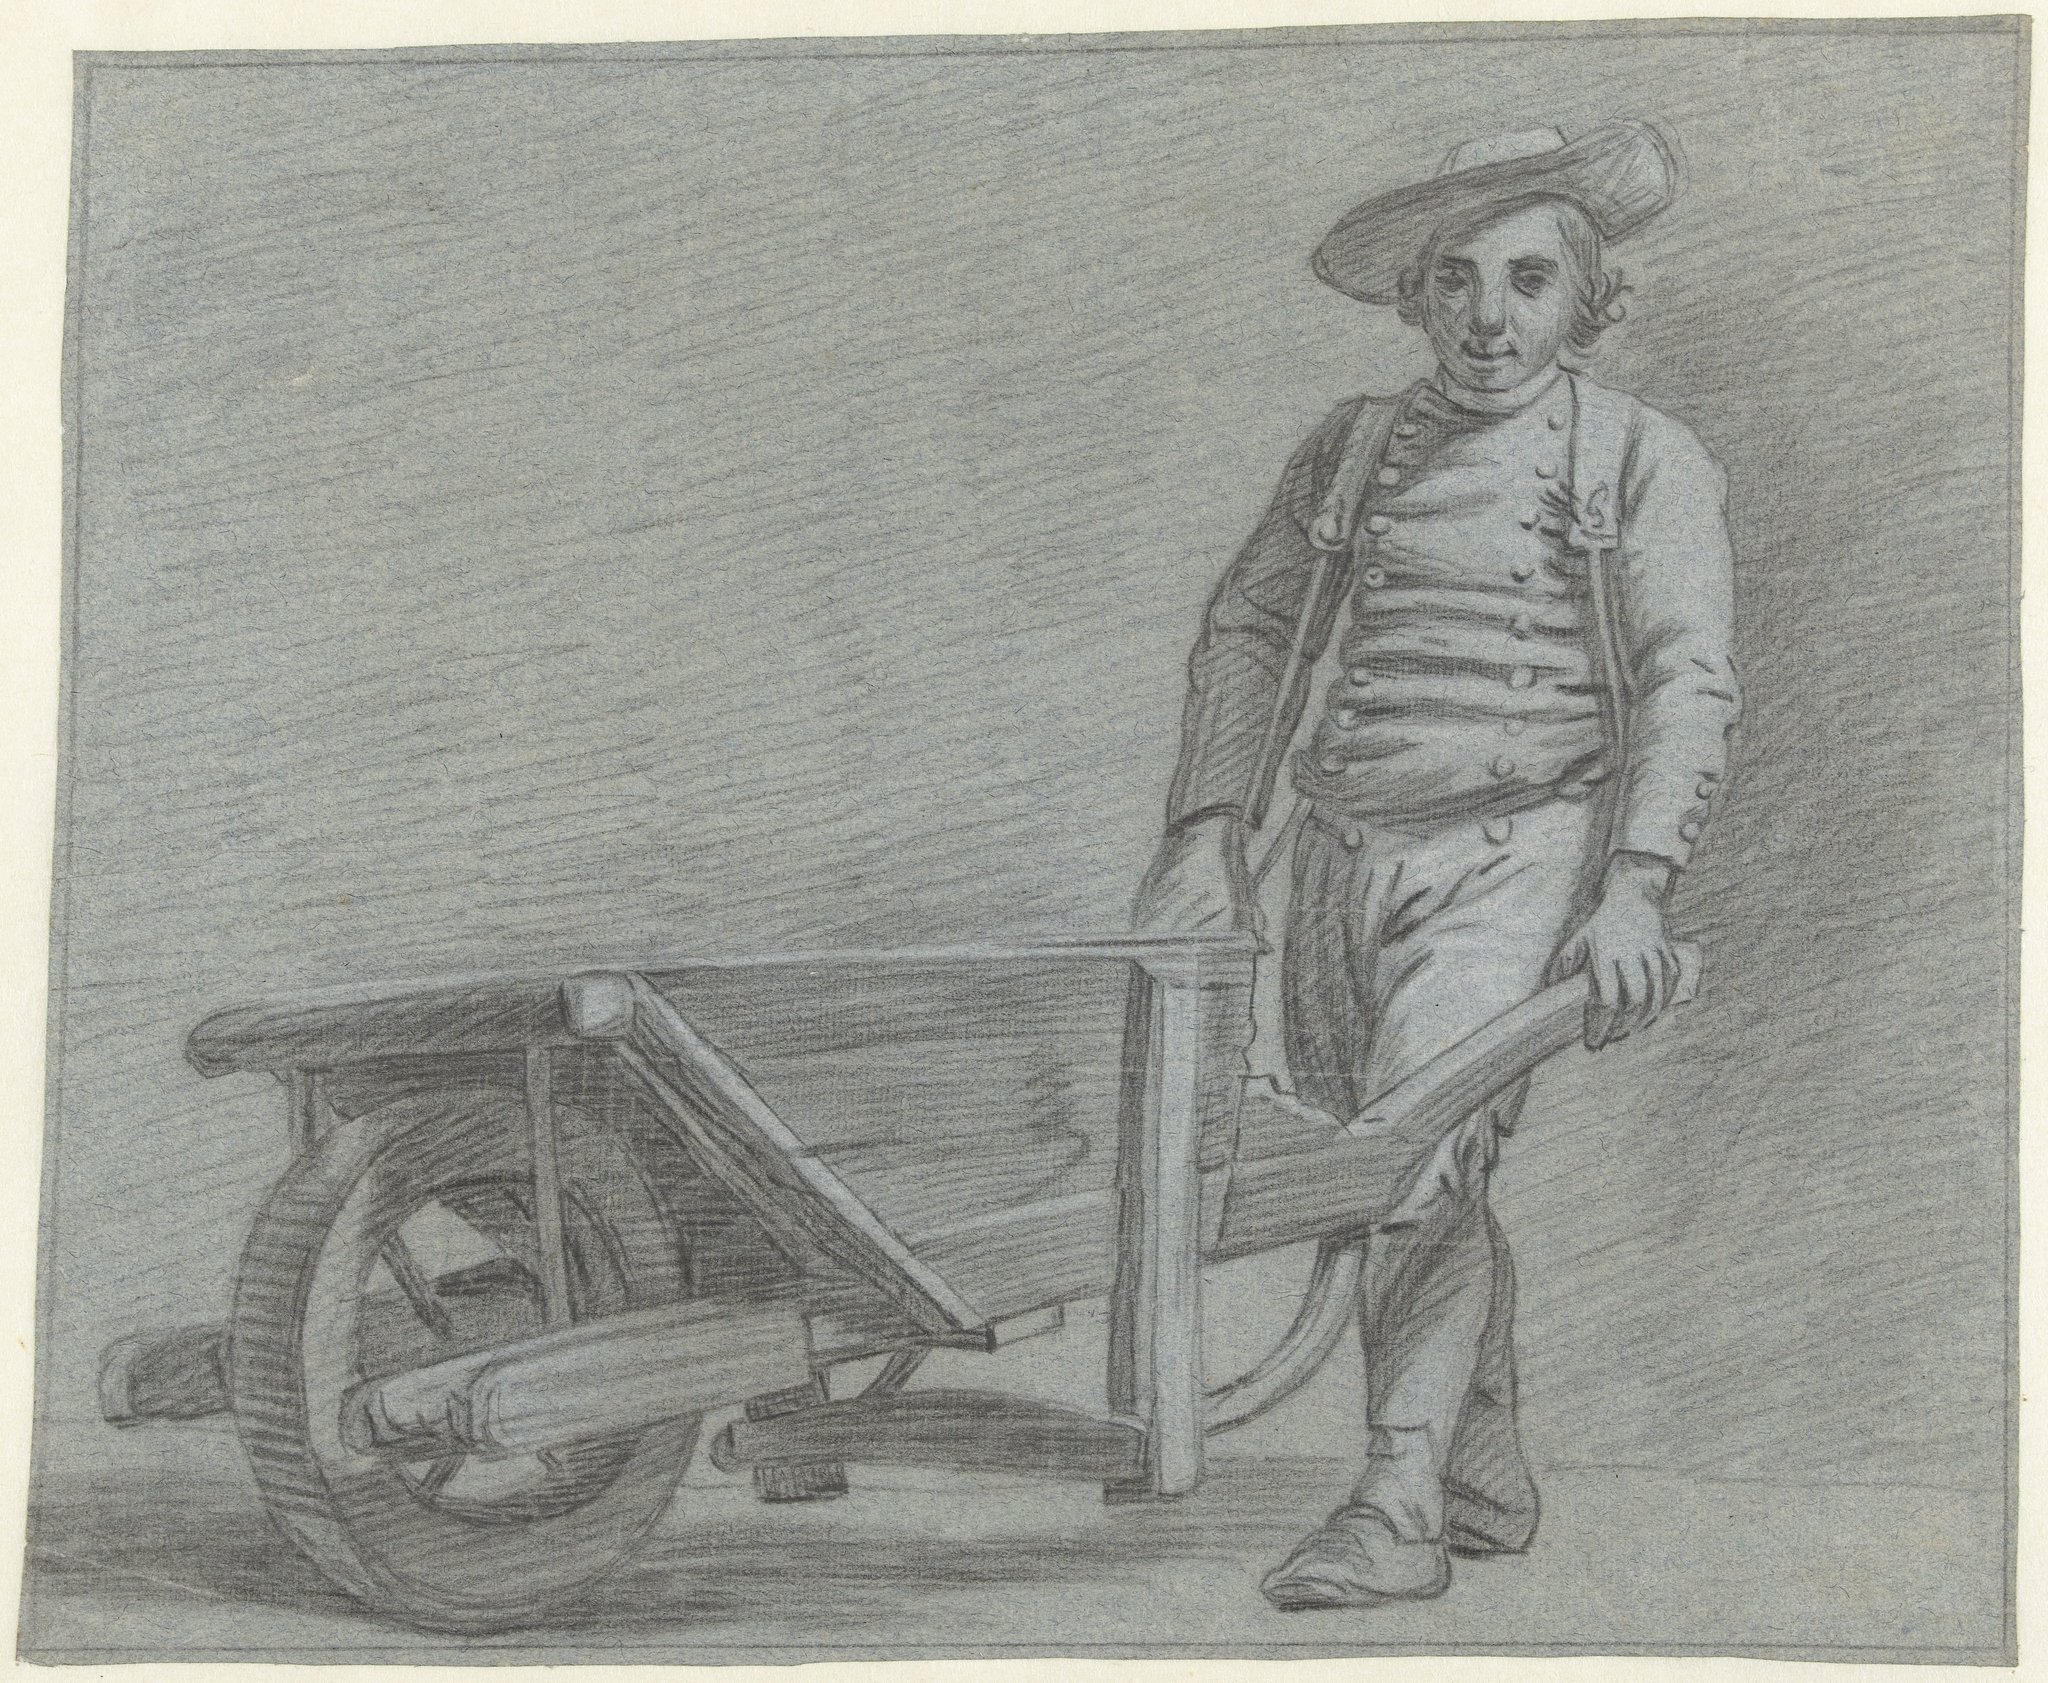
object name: drawing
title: Staande man met kruiwagen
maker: jordanus hoorn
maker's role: draughtsman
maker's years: 1753-1833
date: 1763-1833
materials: chalk, paper